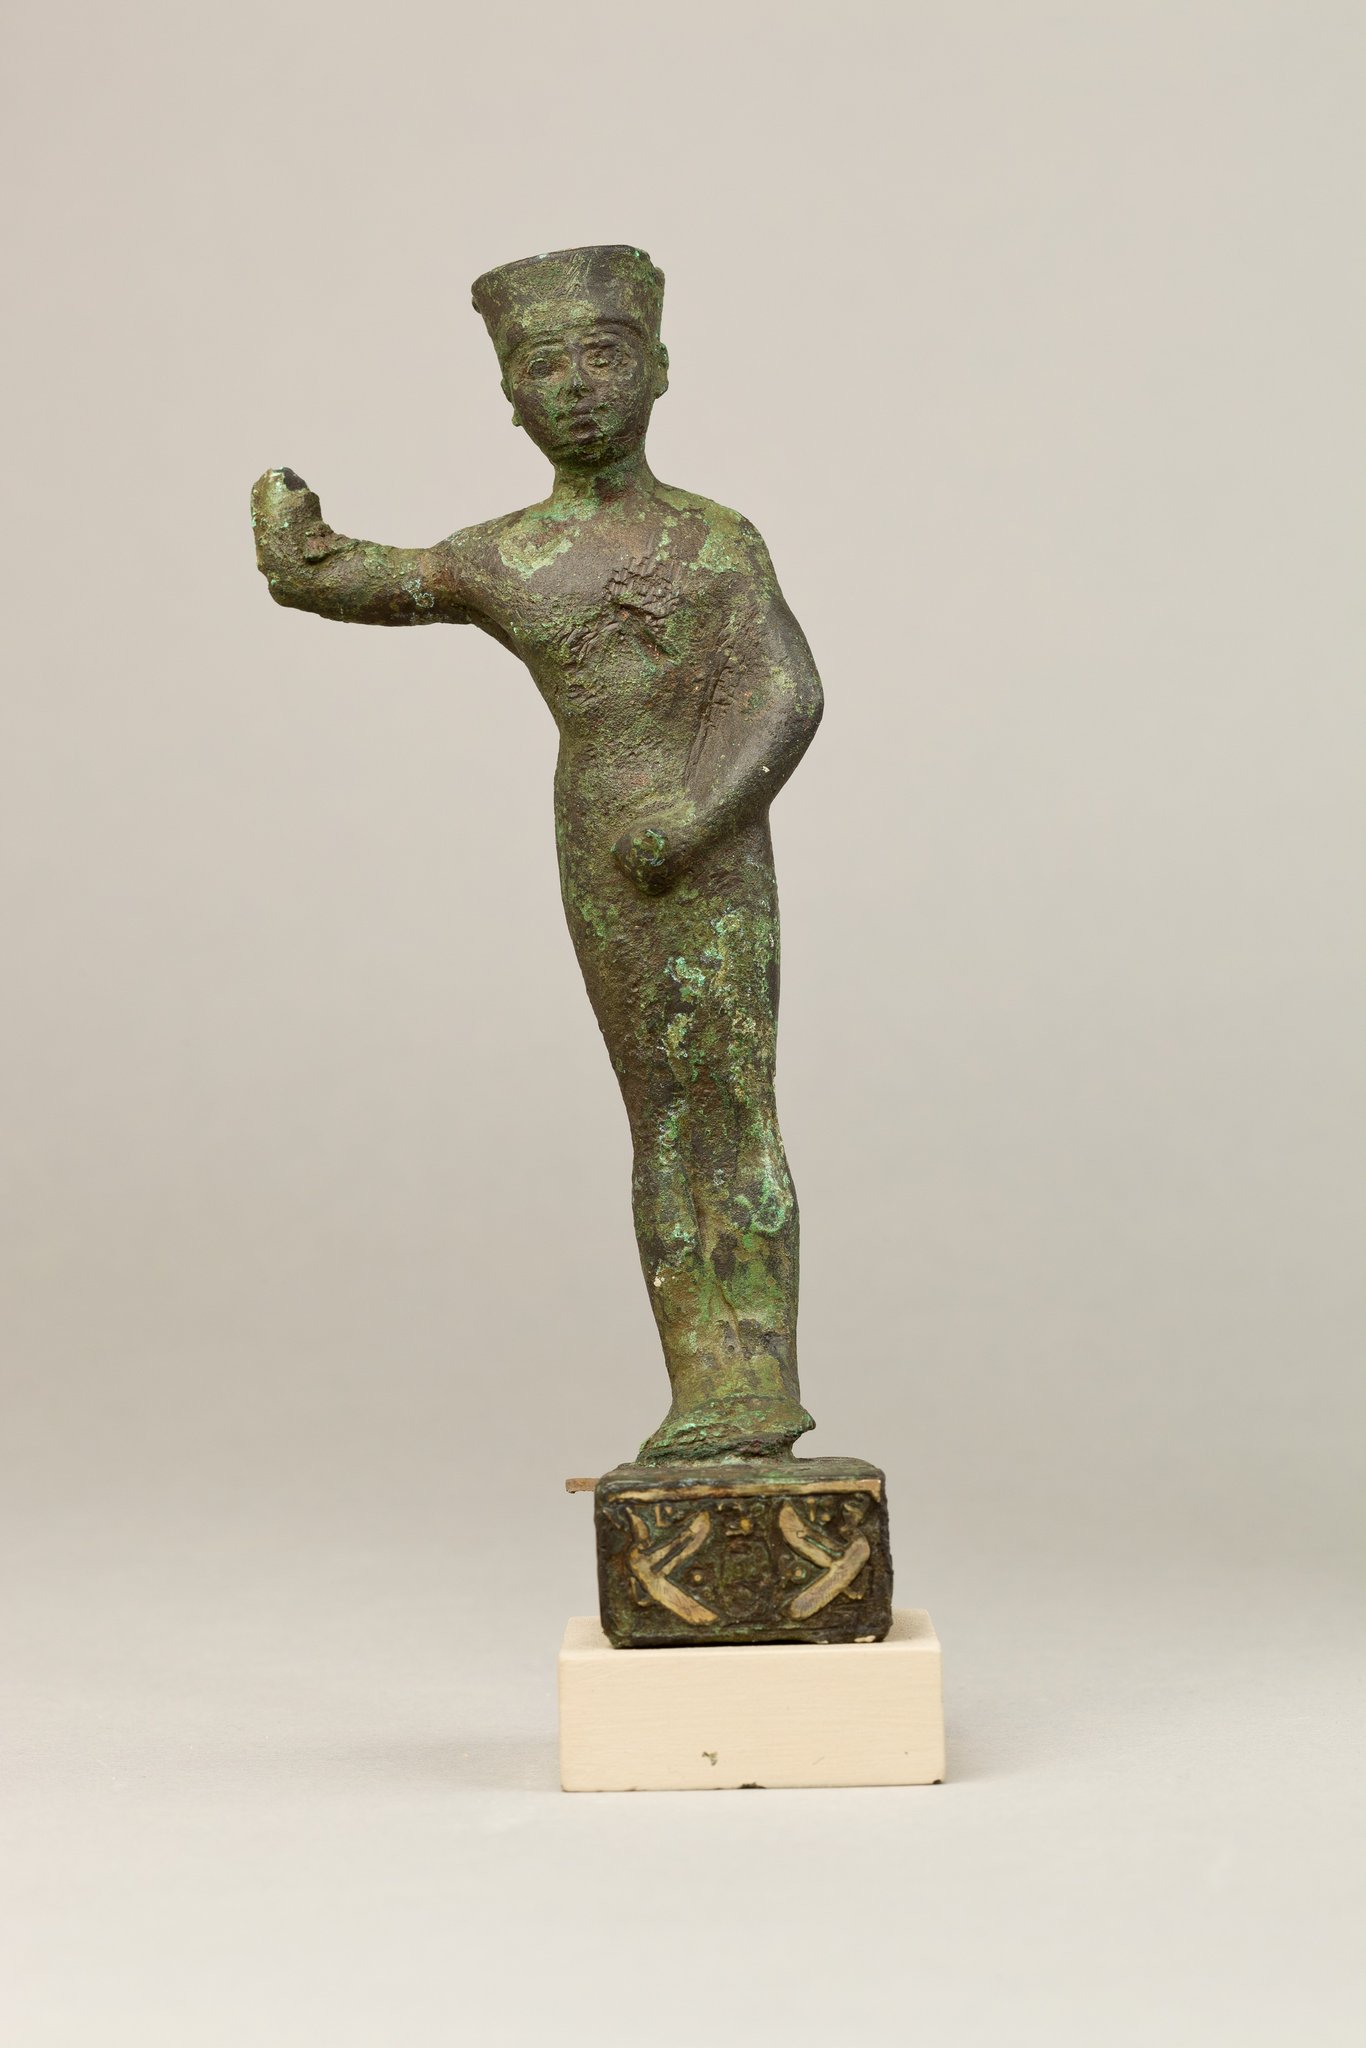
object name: statuette, amenopet, inlaid base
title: Statuette of Amenopet naming the provider/beneficiary Amenirdis son of Horiaa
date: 800-595 BCE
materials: metal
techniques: inlay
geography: egypt